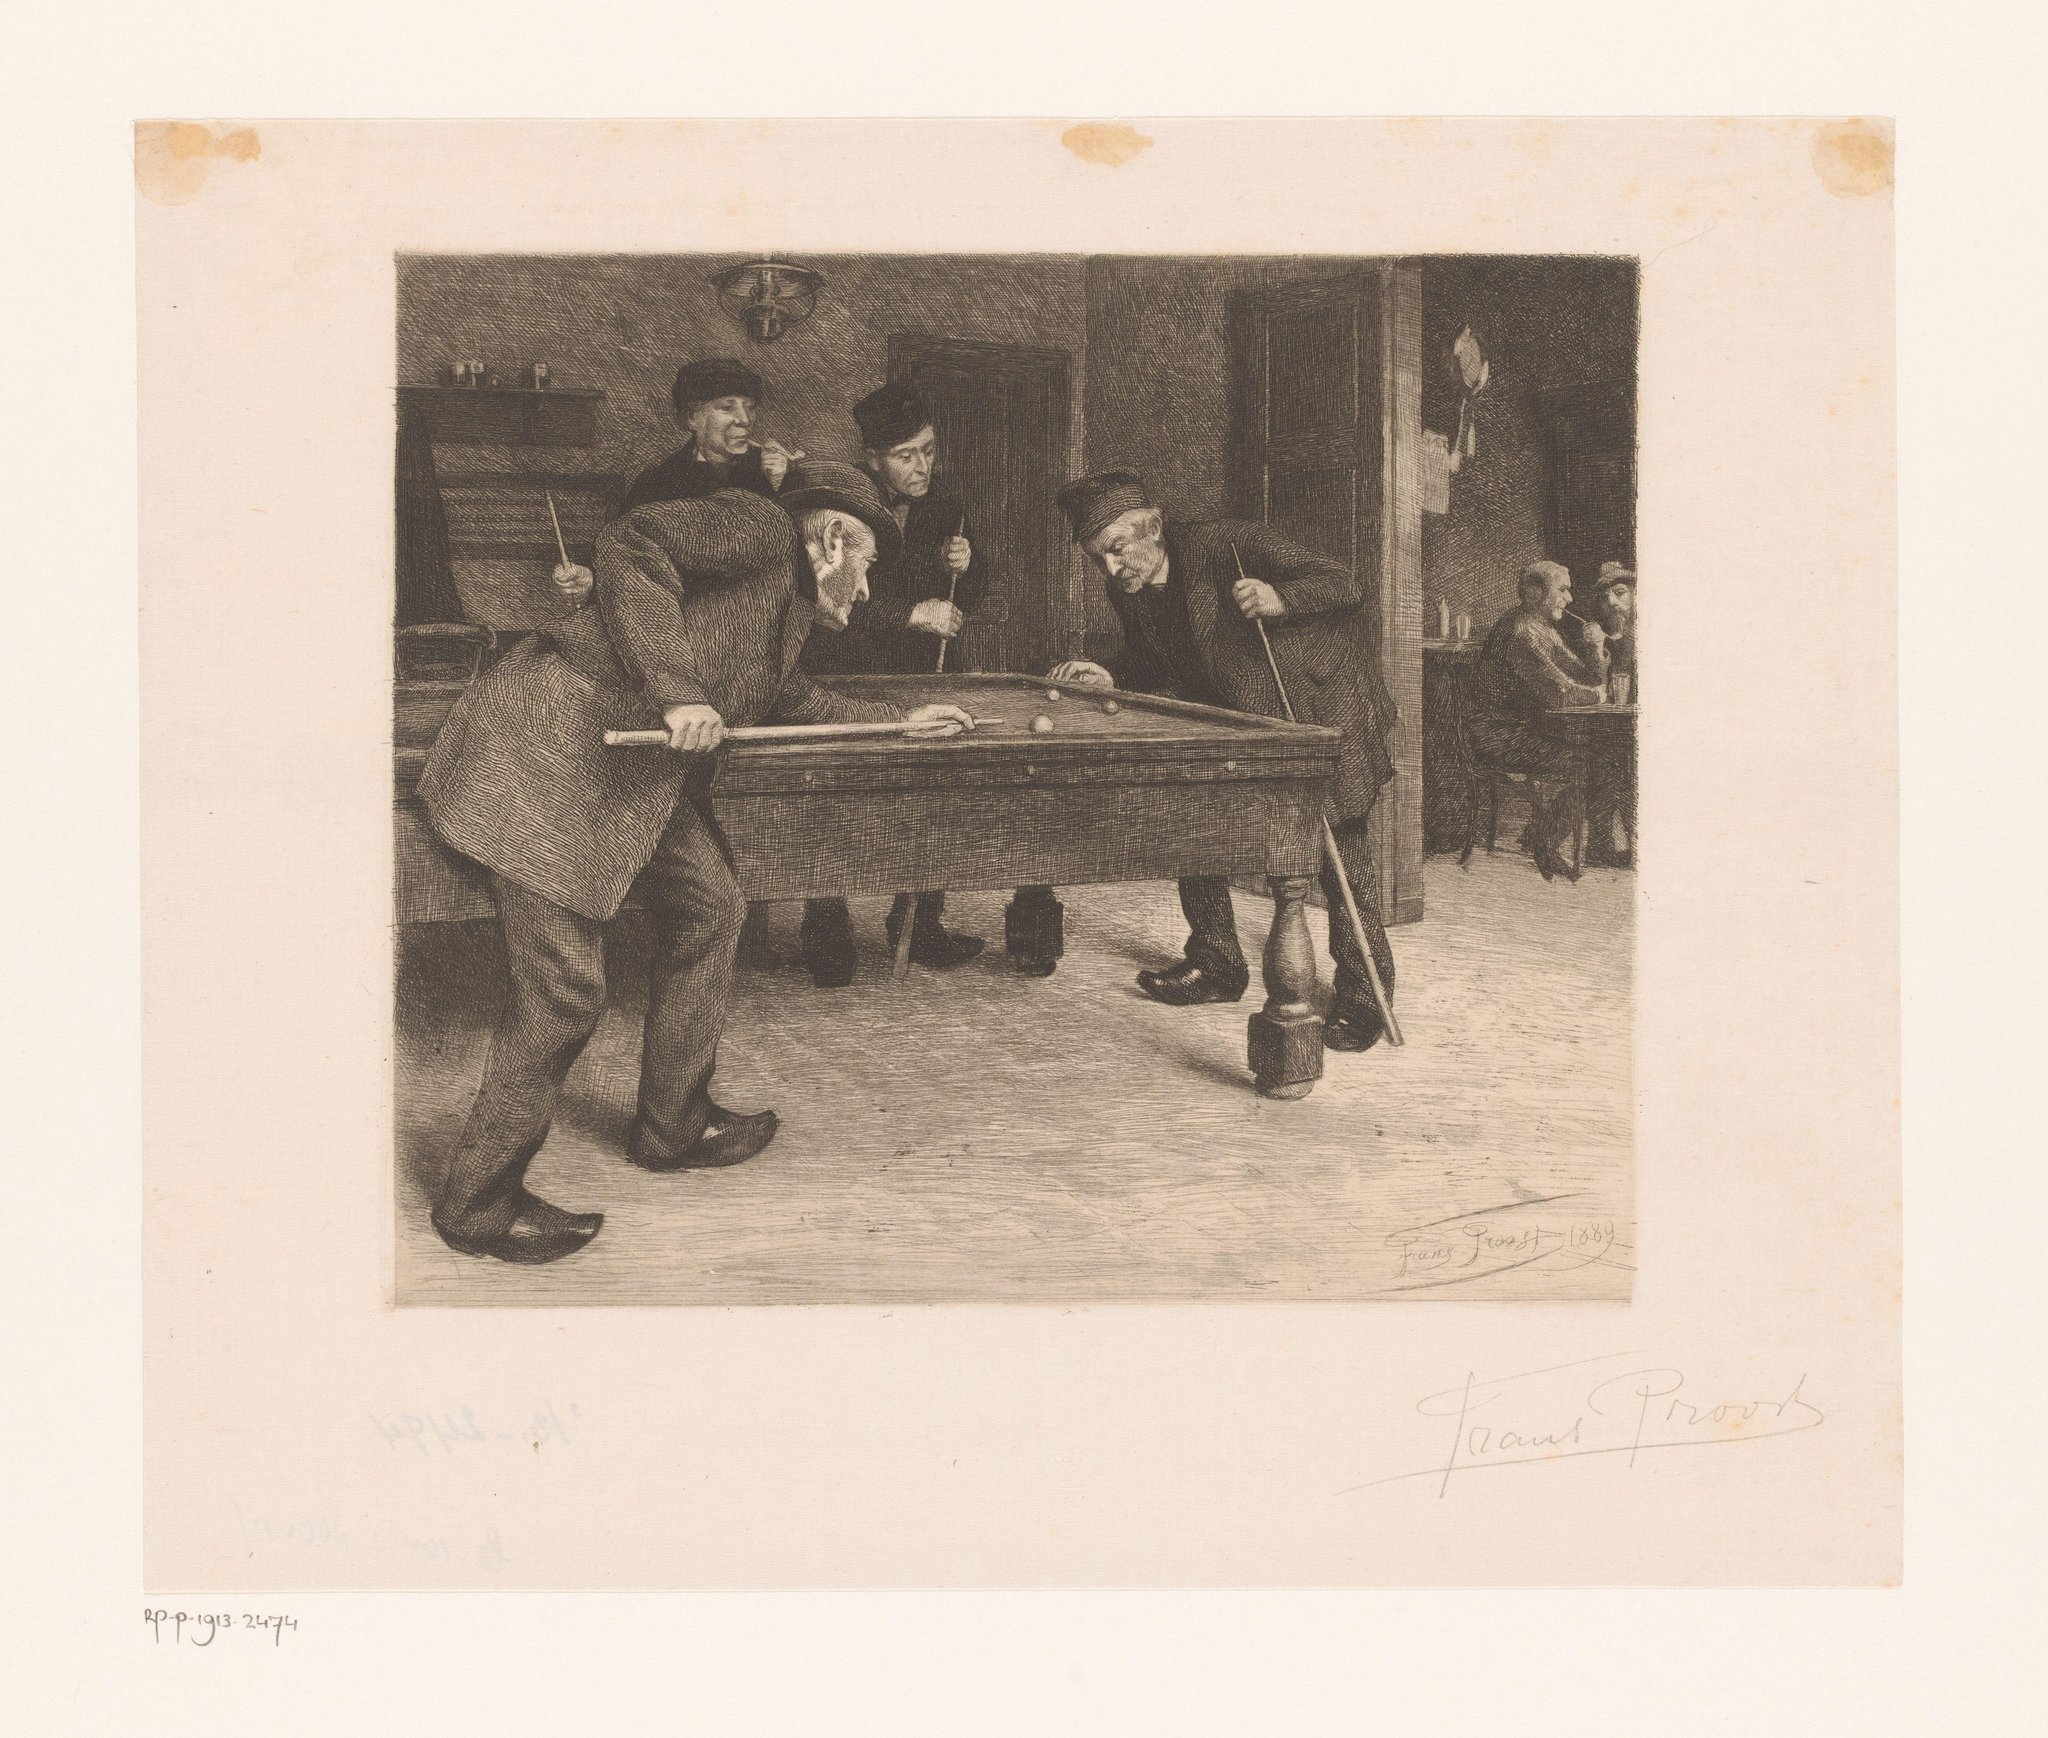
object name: print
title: Biljartende mannen in een café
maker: frans proost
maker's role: painter, print maker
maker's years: 1875-1941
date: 1889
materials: paper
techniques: drypoint, etching, intaglio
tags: billiards, inn, coffee-house, public house, etc., pipe ~ tobacco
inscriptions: collector's mark: Lugt 2228, workshop stamp: ‘Antwerpsche Etsers 1880’